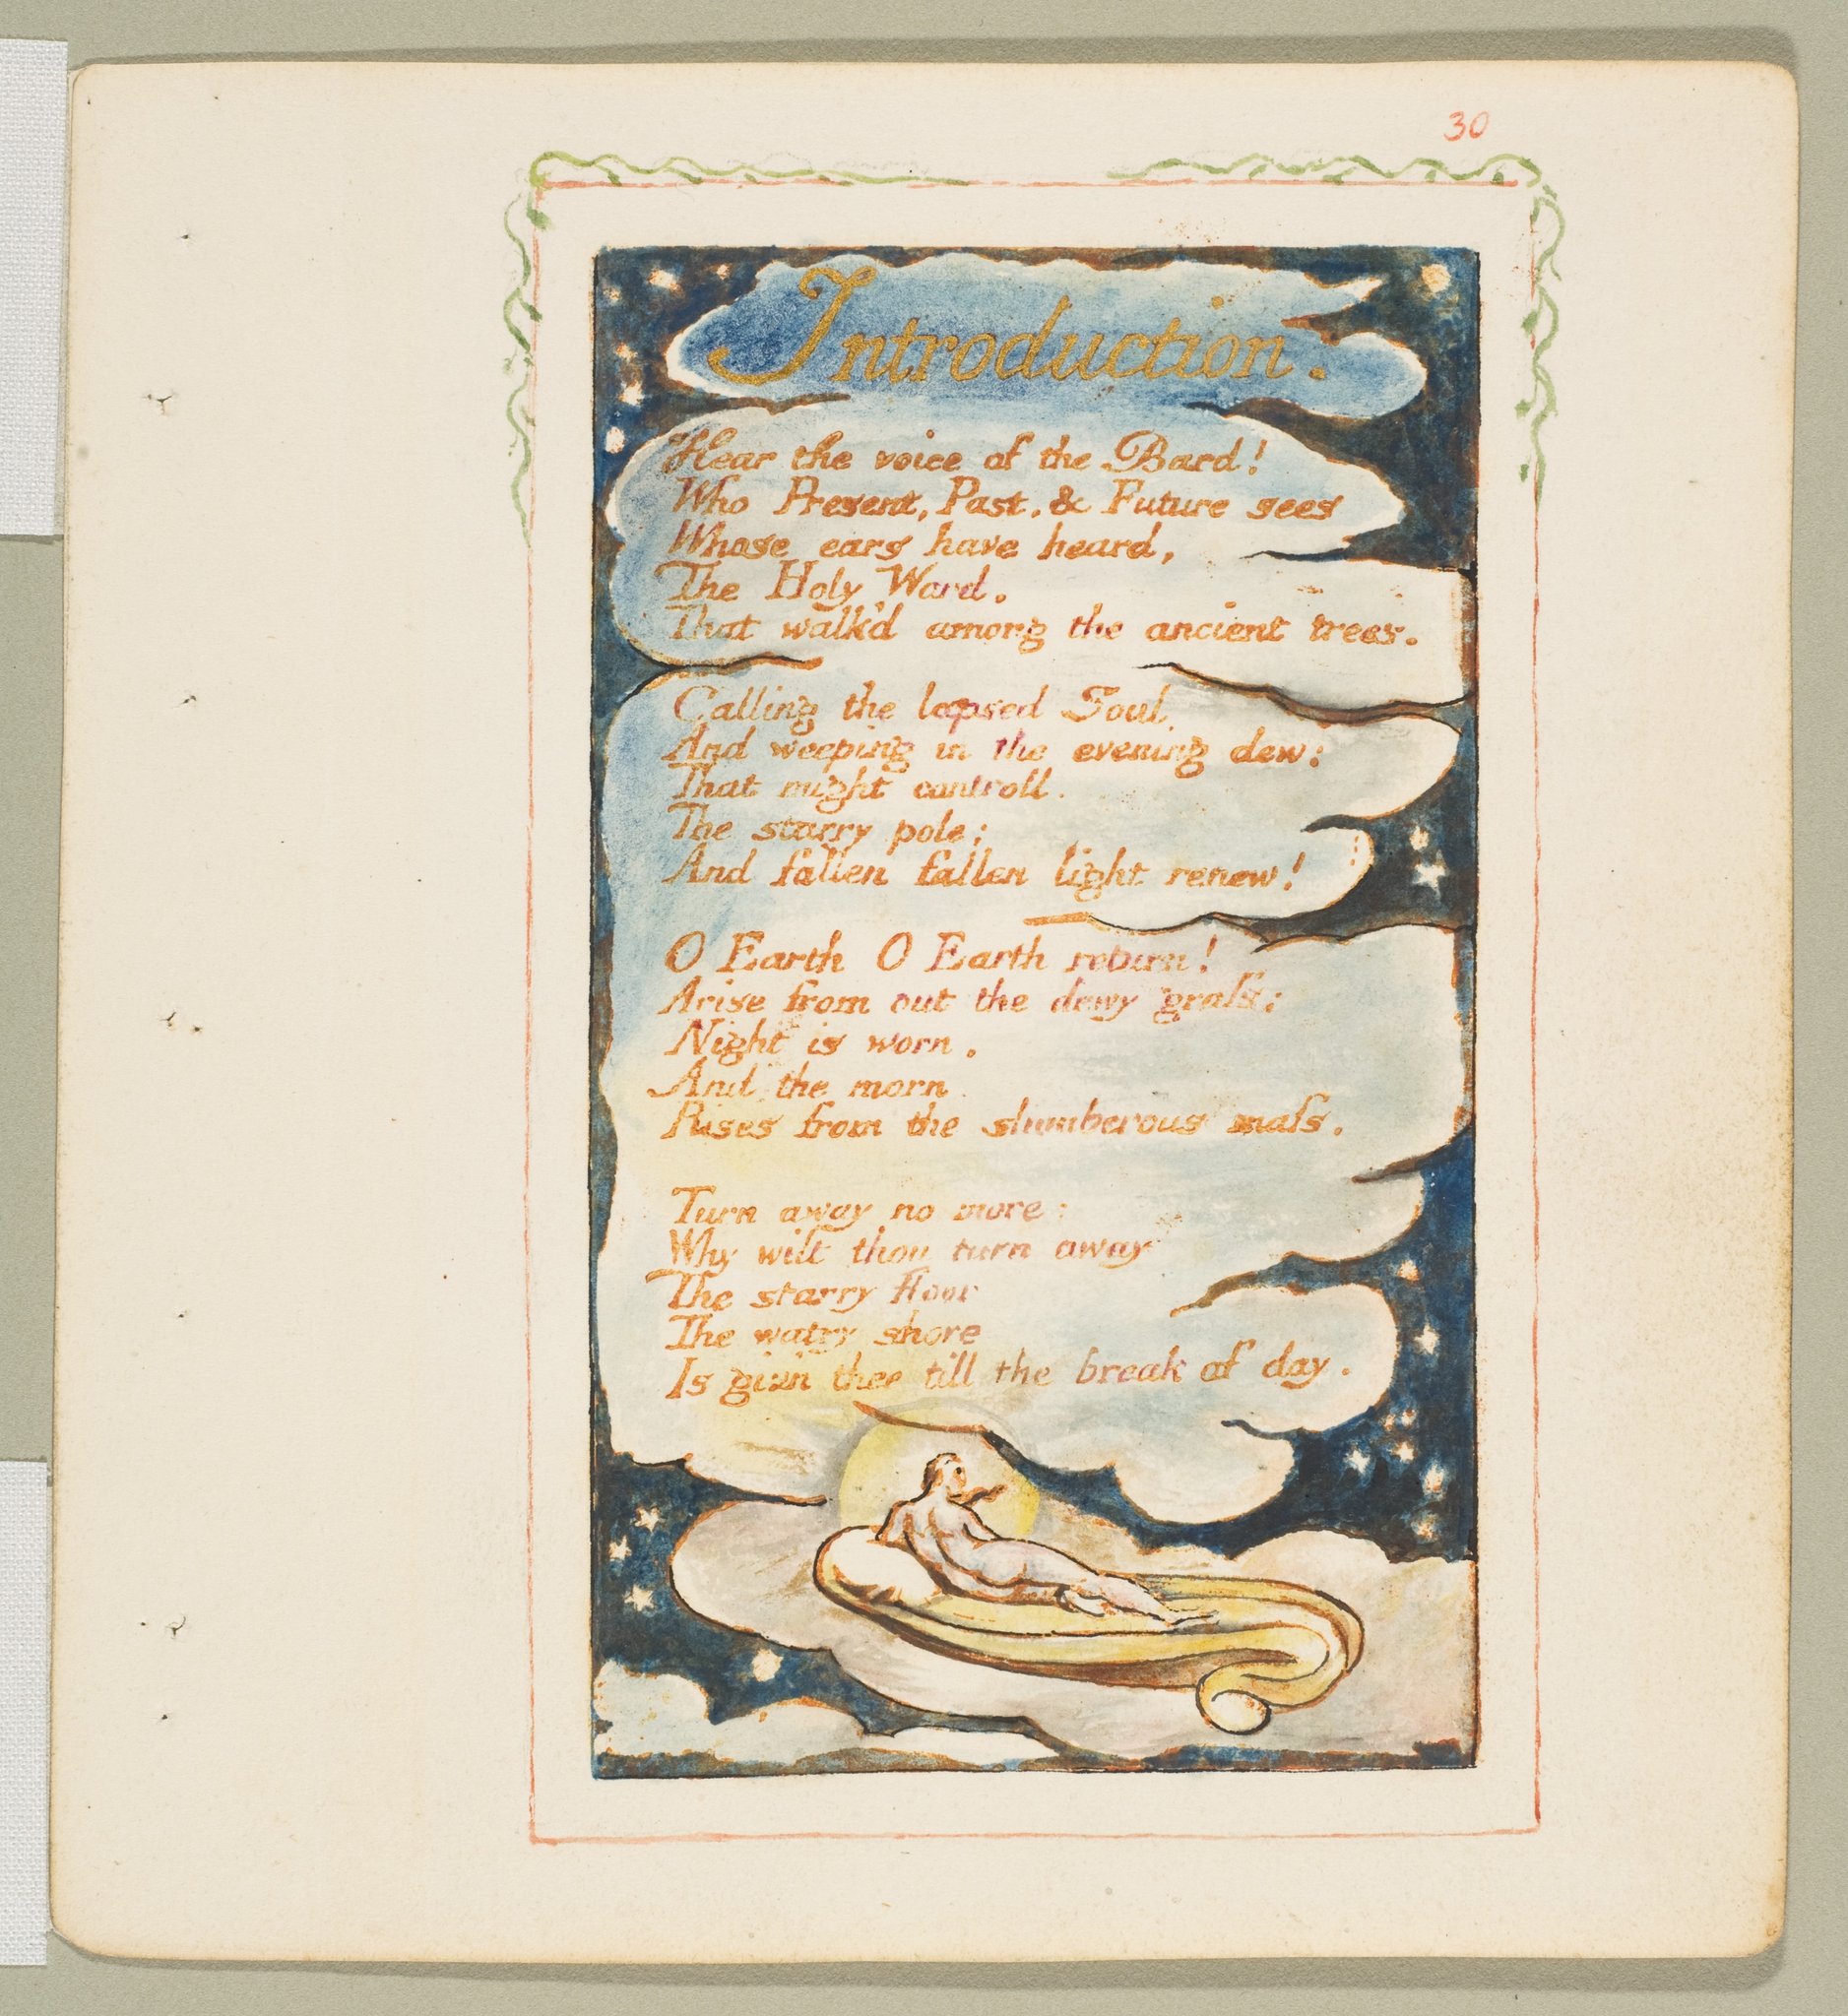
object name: print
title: Songs of Experience: Introduction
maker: william blake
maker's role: artist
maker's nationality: british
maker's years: 1757-1827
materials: gold, ink, shell, watercolor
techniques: etching, hand coloring, printing, relief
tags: poetry,male nudes